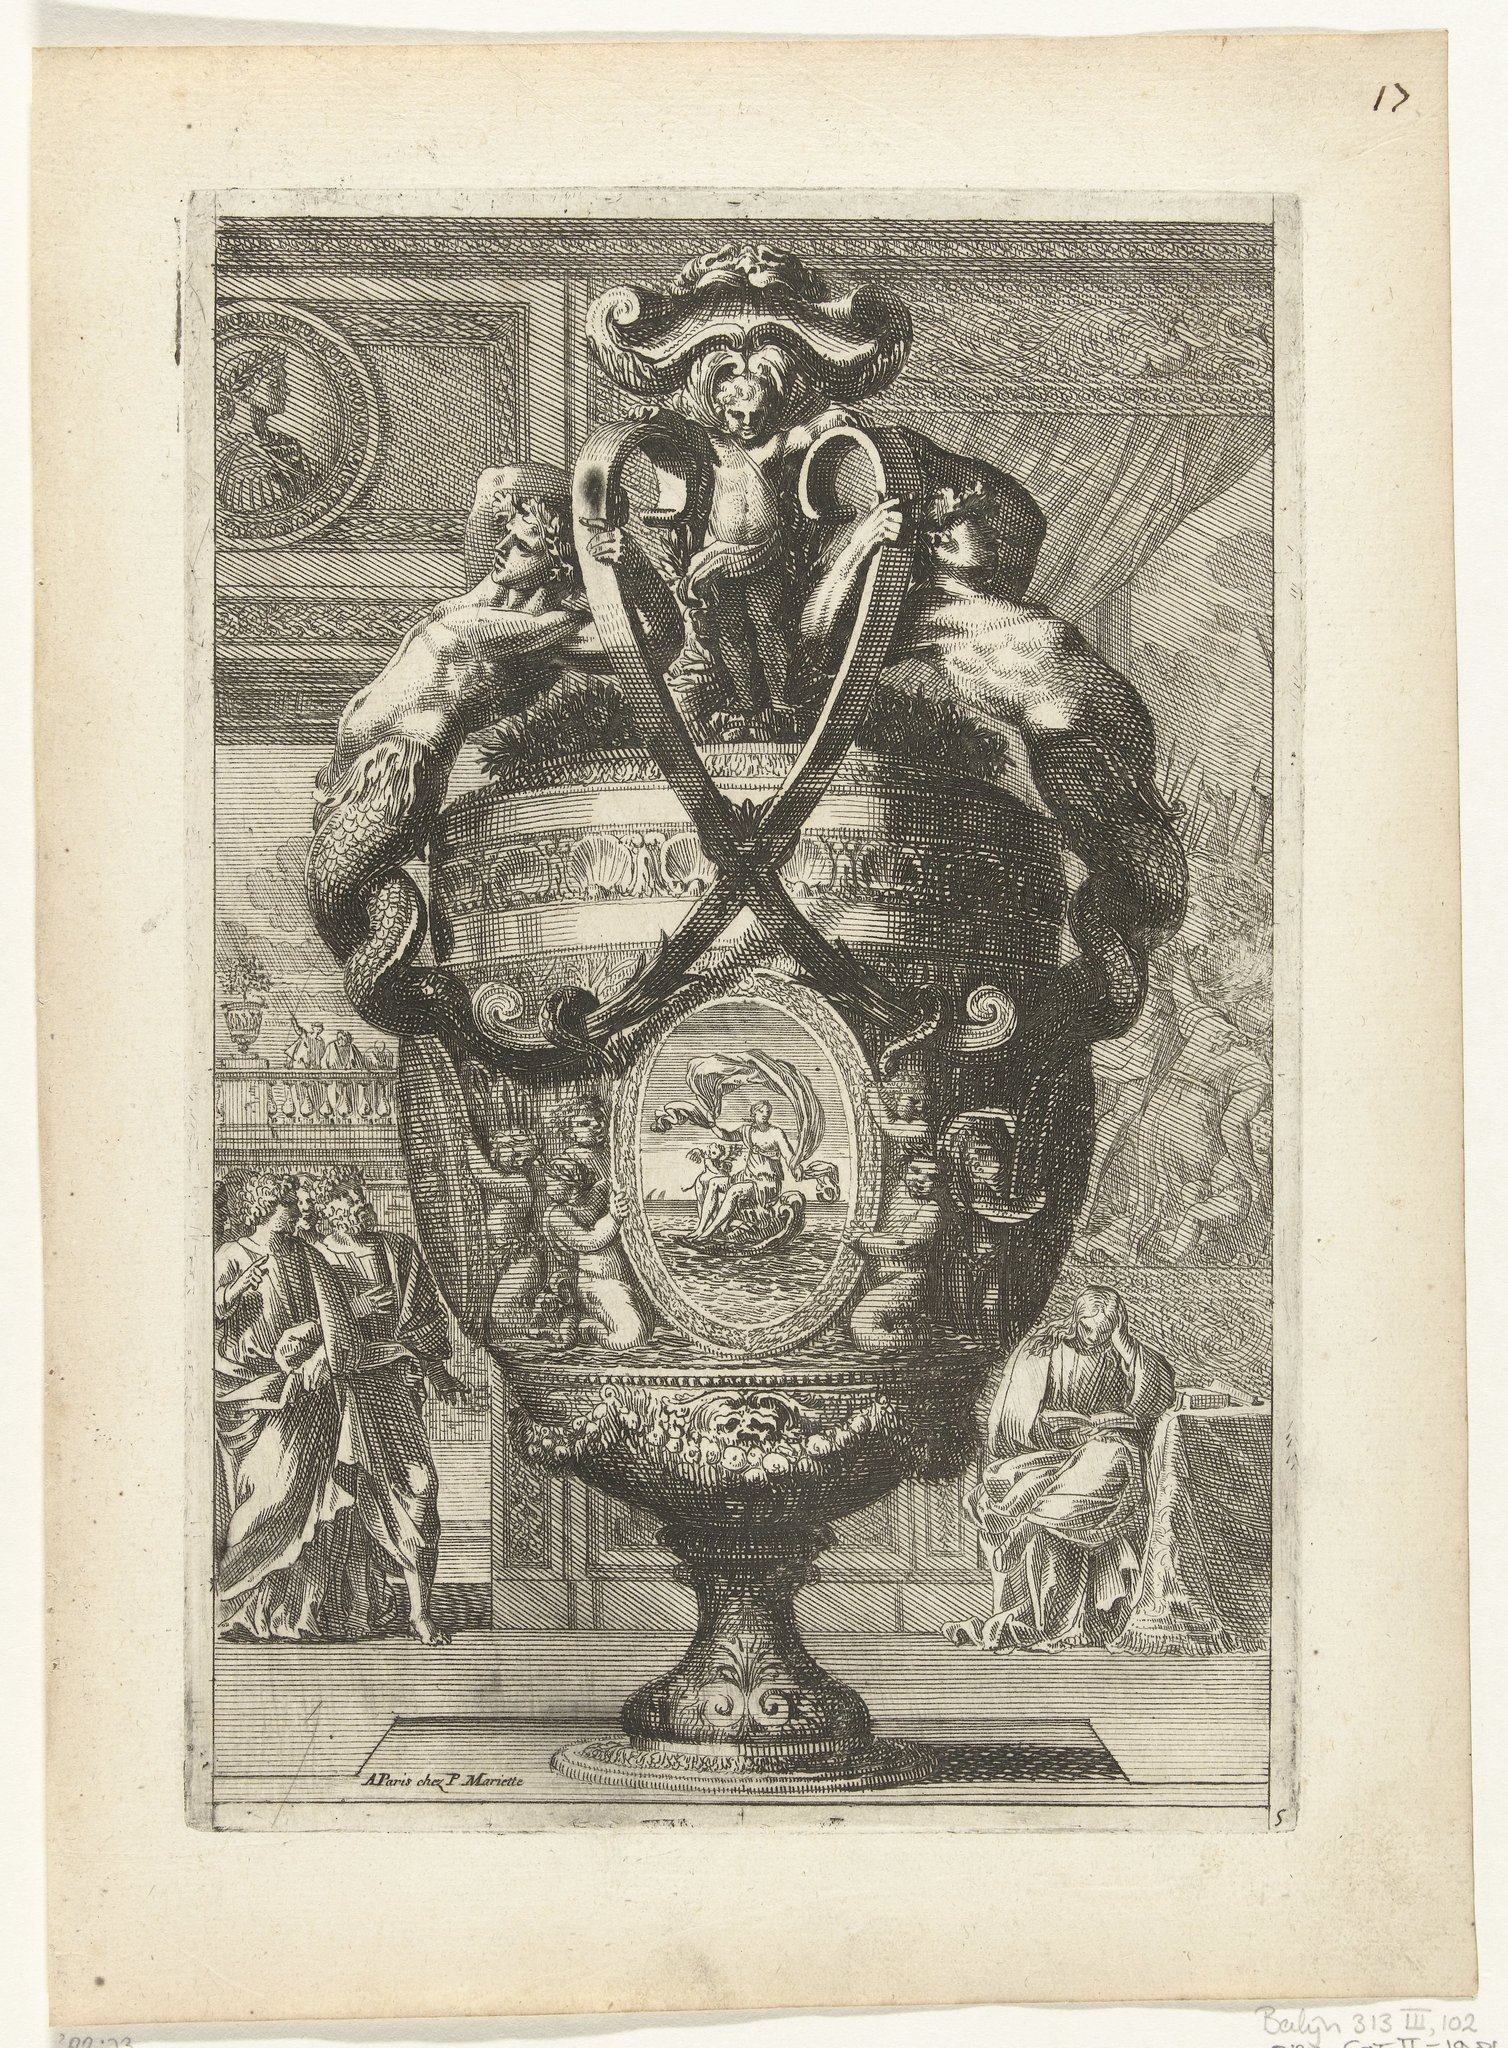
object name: print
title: Vaas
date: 1659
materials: paper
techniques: etching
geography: paris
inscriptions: number: ‘17’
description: De vaas heeft handvatten in de vorm van tritons, onder de tuit staat een putto.